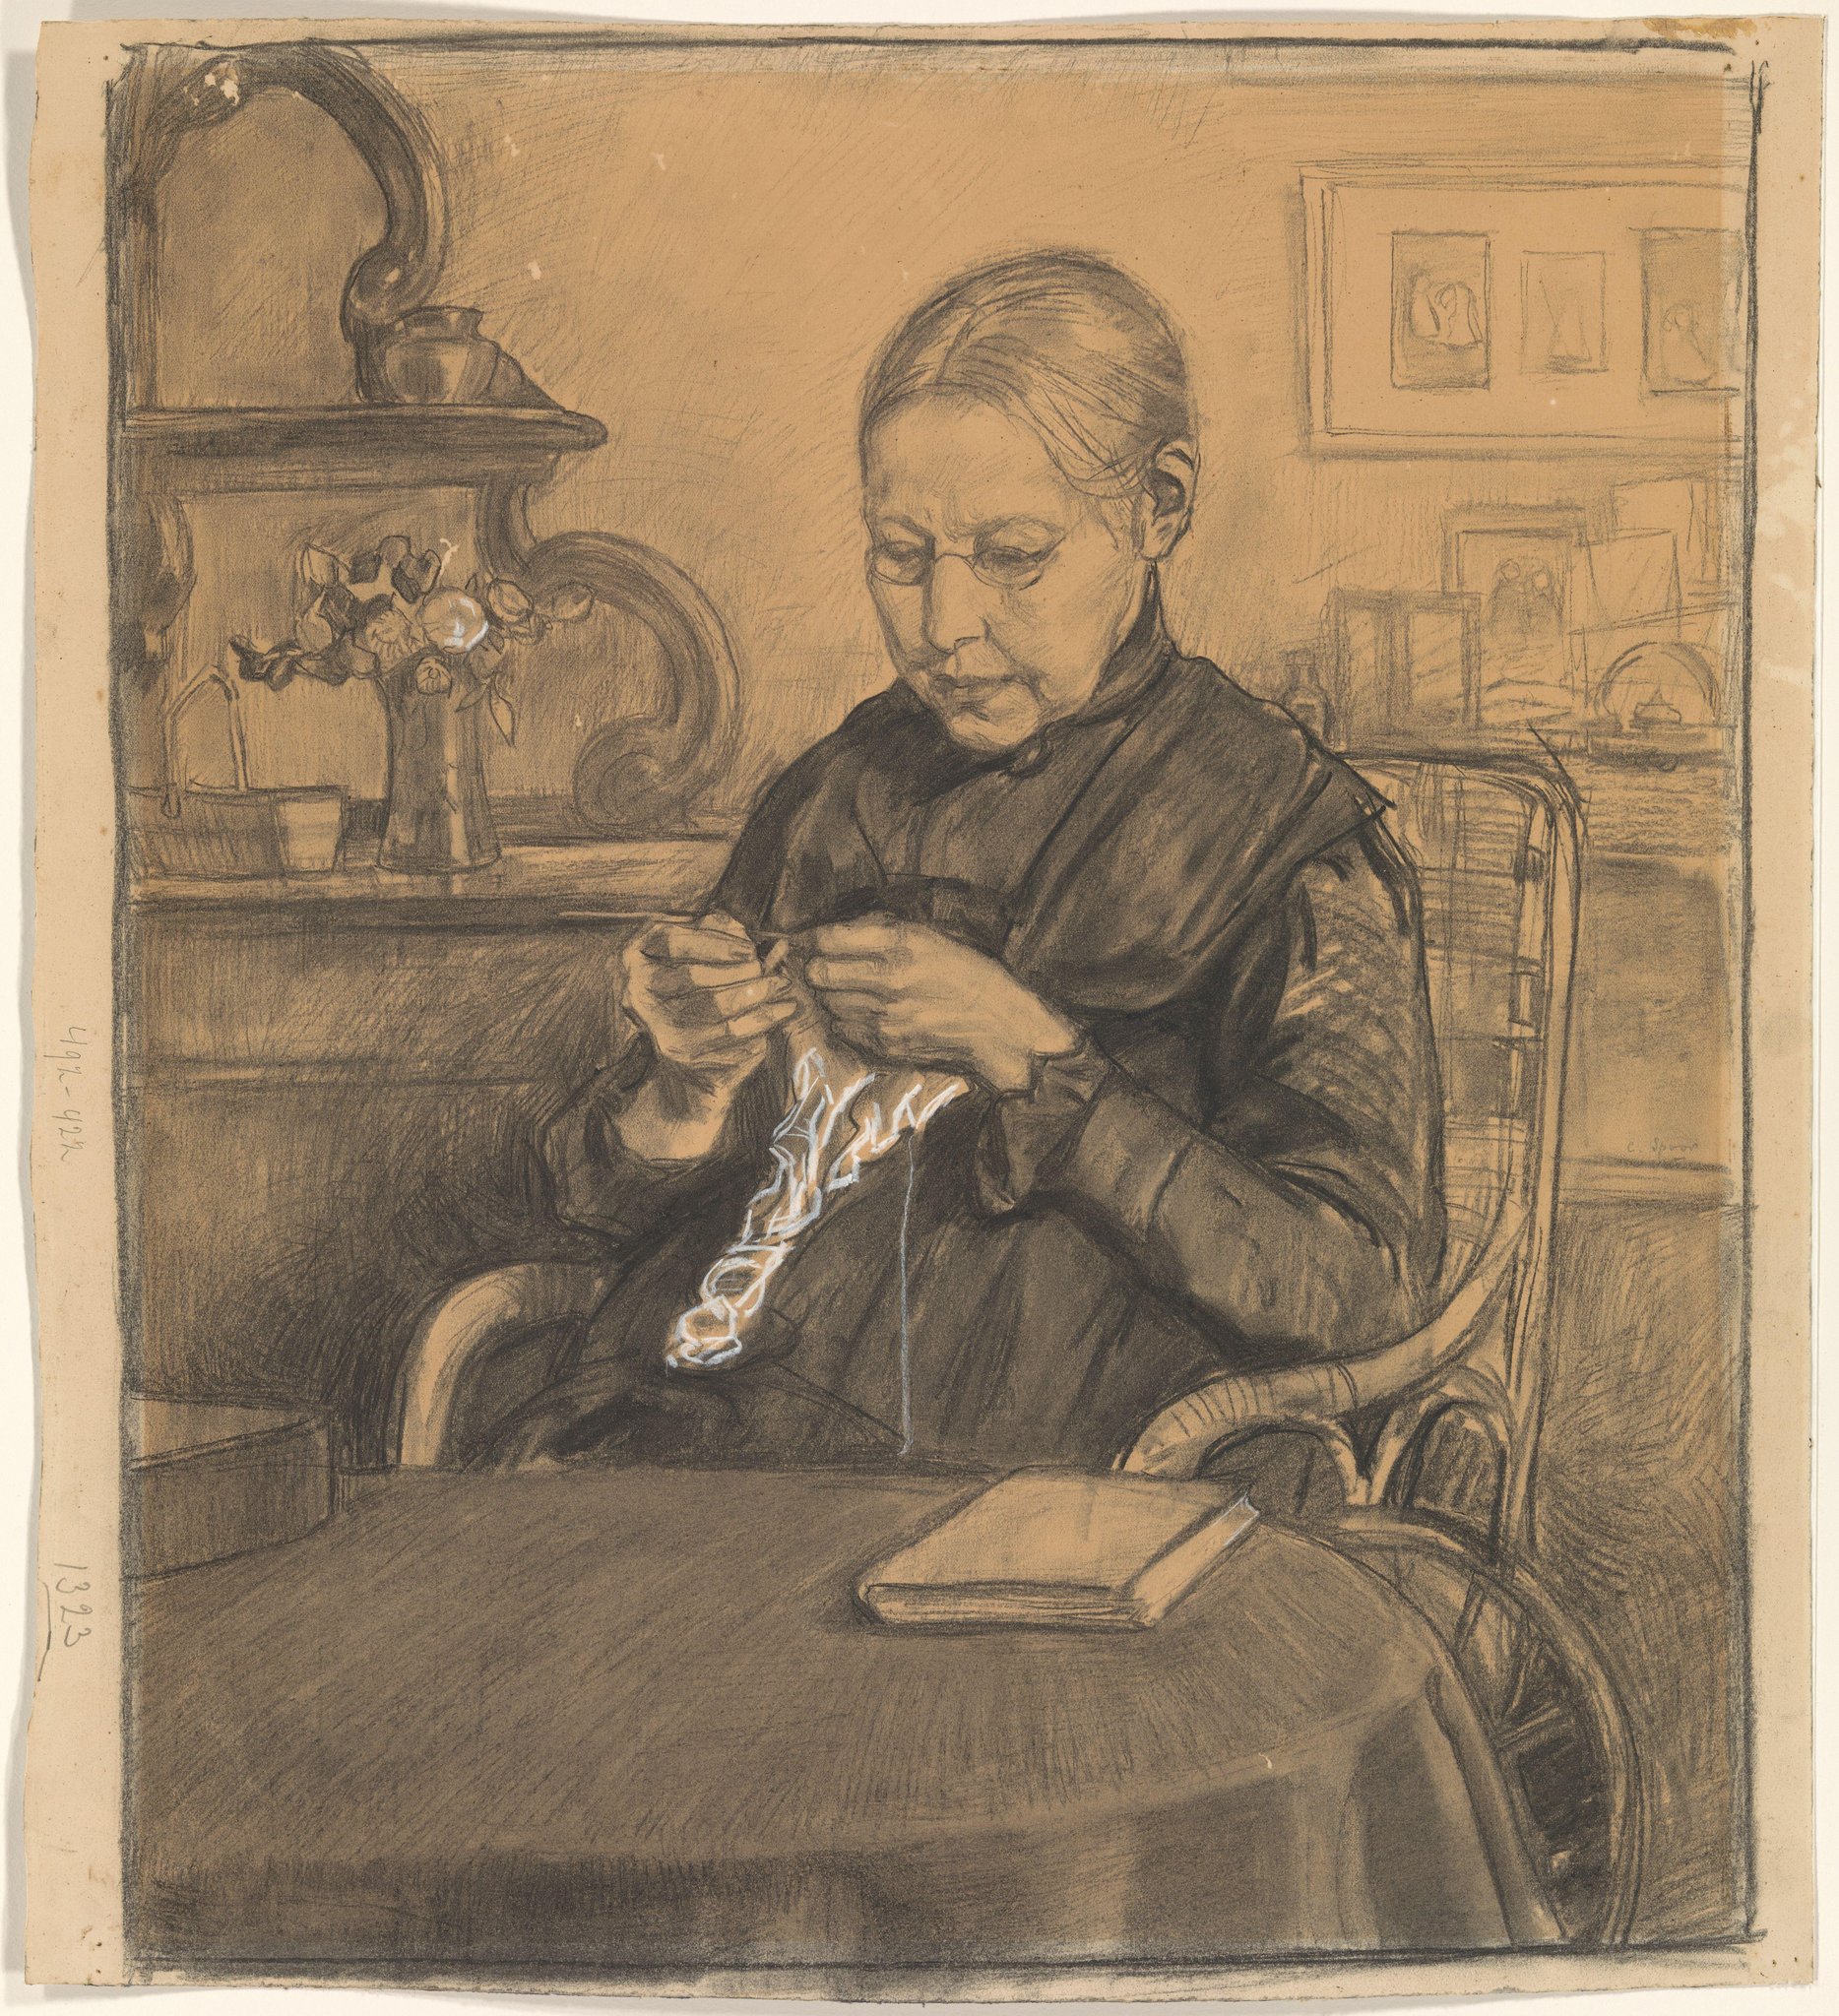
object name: drawing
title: Breiende vrouw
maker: cornelis spoor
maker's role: draughtsman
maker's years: 1867-1928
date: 1877-1928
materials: chalk, paper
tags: knitting, (other forms of) needlework, e.g.: crocheting, knitting, embroidering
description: Breiende vrouw met bril bij tafel met boek.